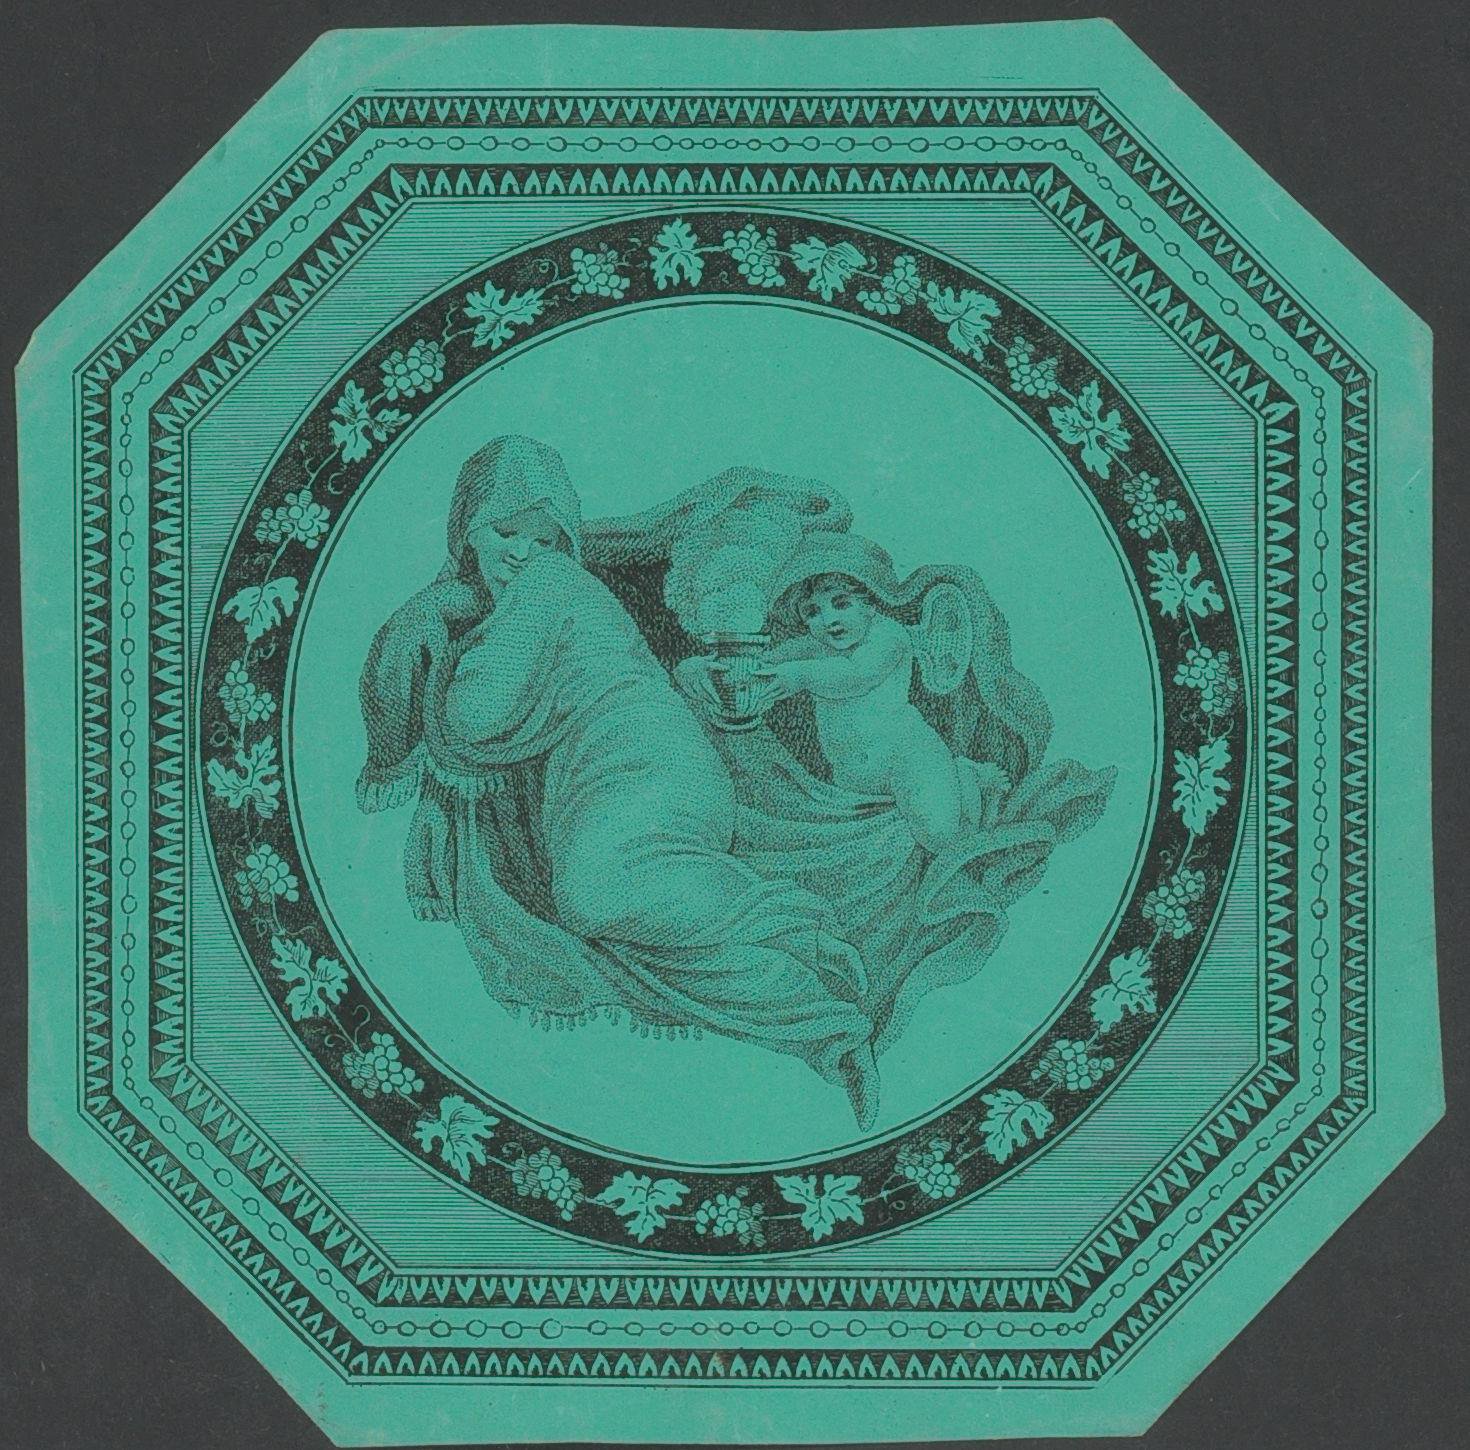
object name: print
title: Liggende vrouw in een mantel met een putto met wierook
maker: Anonymous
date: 1800-1849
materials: paper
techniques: etching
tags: incense-burner ~ scents, perfumes, sleeping; unconsciousness, resting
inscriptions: stamp, collector's mark: Lugt 1641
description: Liggende vrouw in een mantel met een putto met wierook. In een achthoek met een ornamentale lijst. Onderwerpsrubrieken binnen de Atlas Zeden en Gewoonten: Schoone kunsten, Varia.